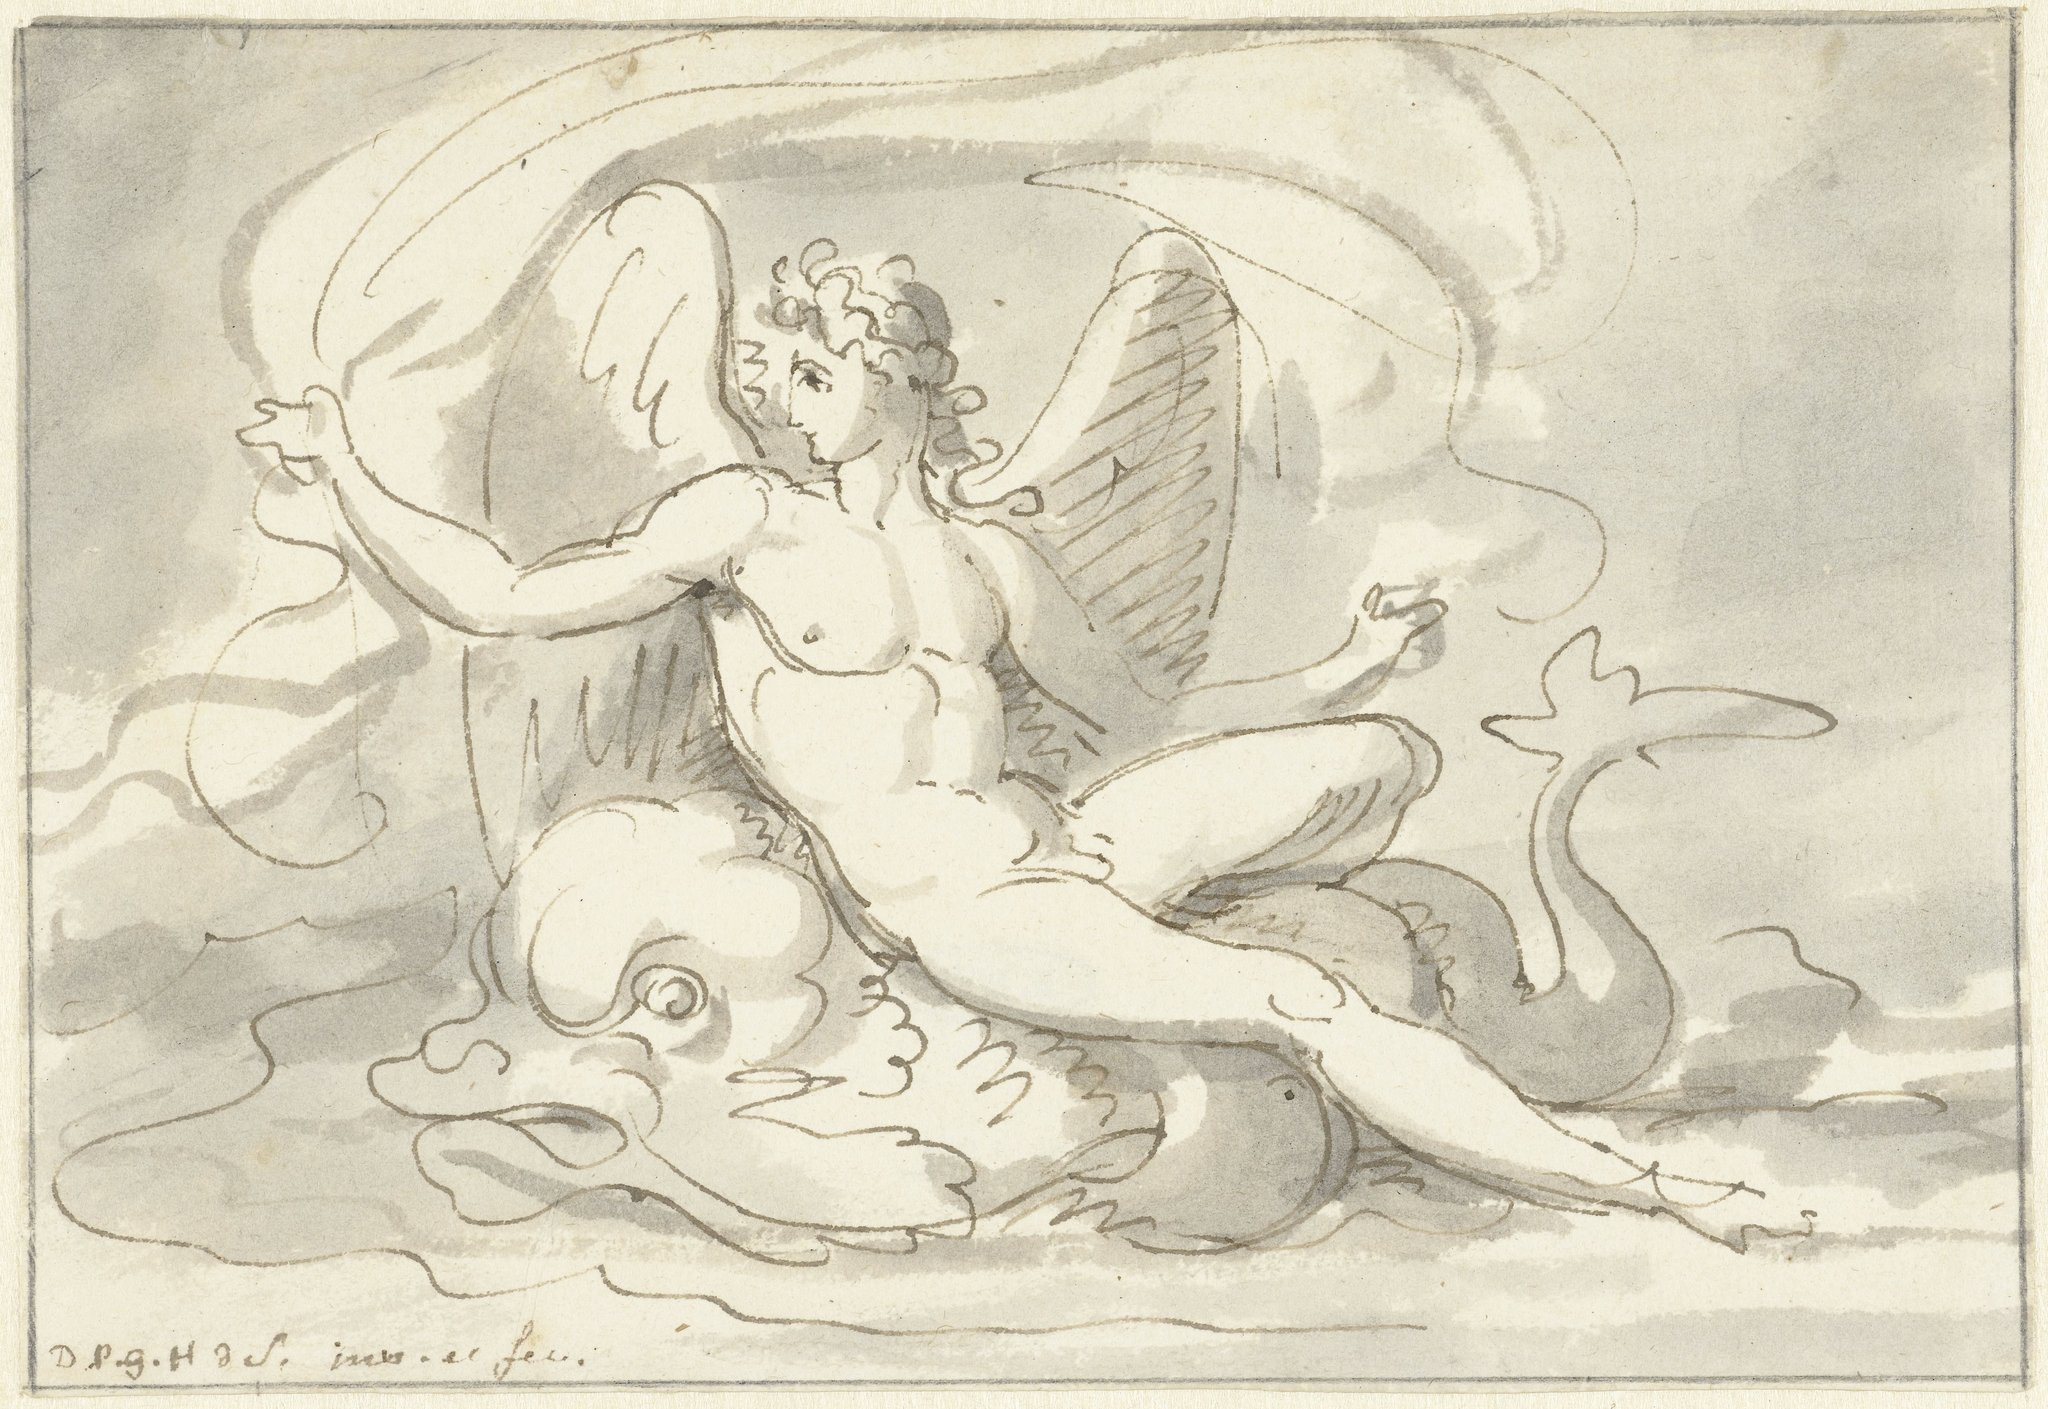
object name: drawing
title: Zeegod op een dolfijn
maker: david pièrre giottino humbert de superville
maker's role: draughtsman, painter, print maker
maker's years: 1770-1849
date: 1780-1849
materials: ink, paper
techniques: brush, pen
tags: triton(s)